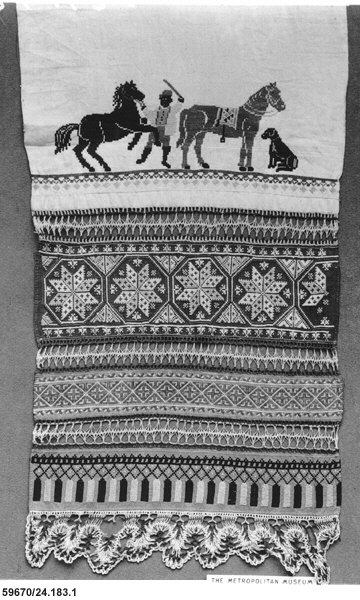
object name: towel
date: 1801-1900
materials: cotton, linen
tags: men,dogs,horses